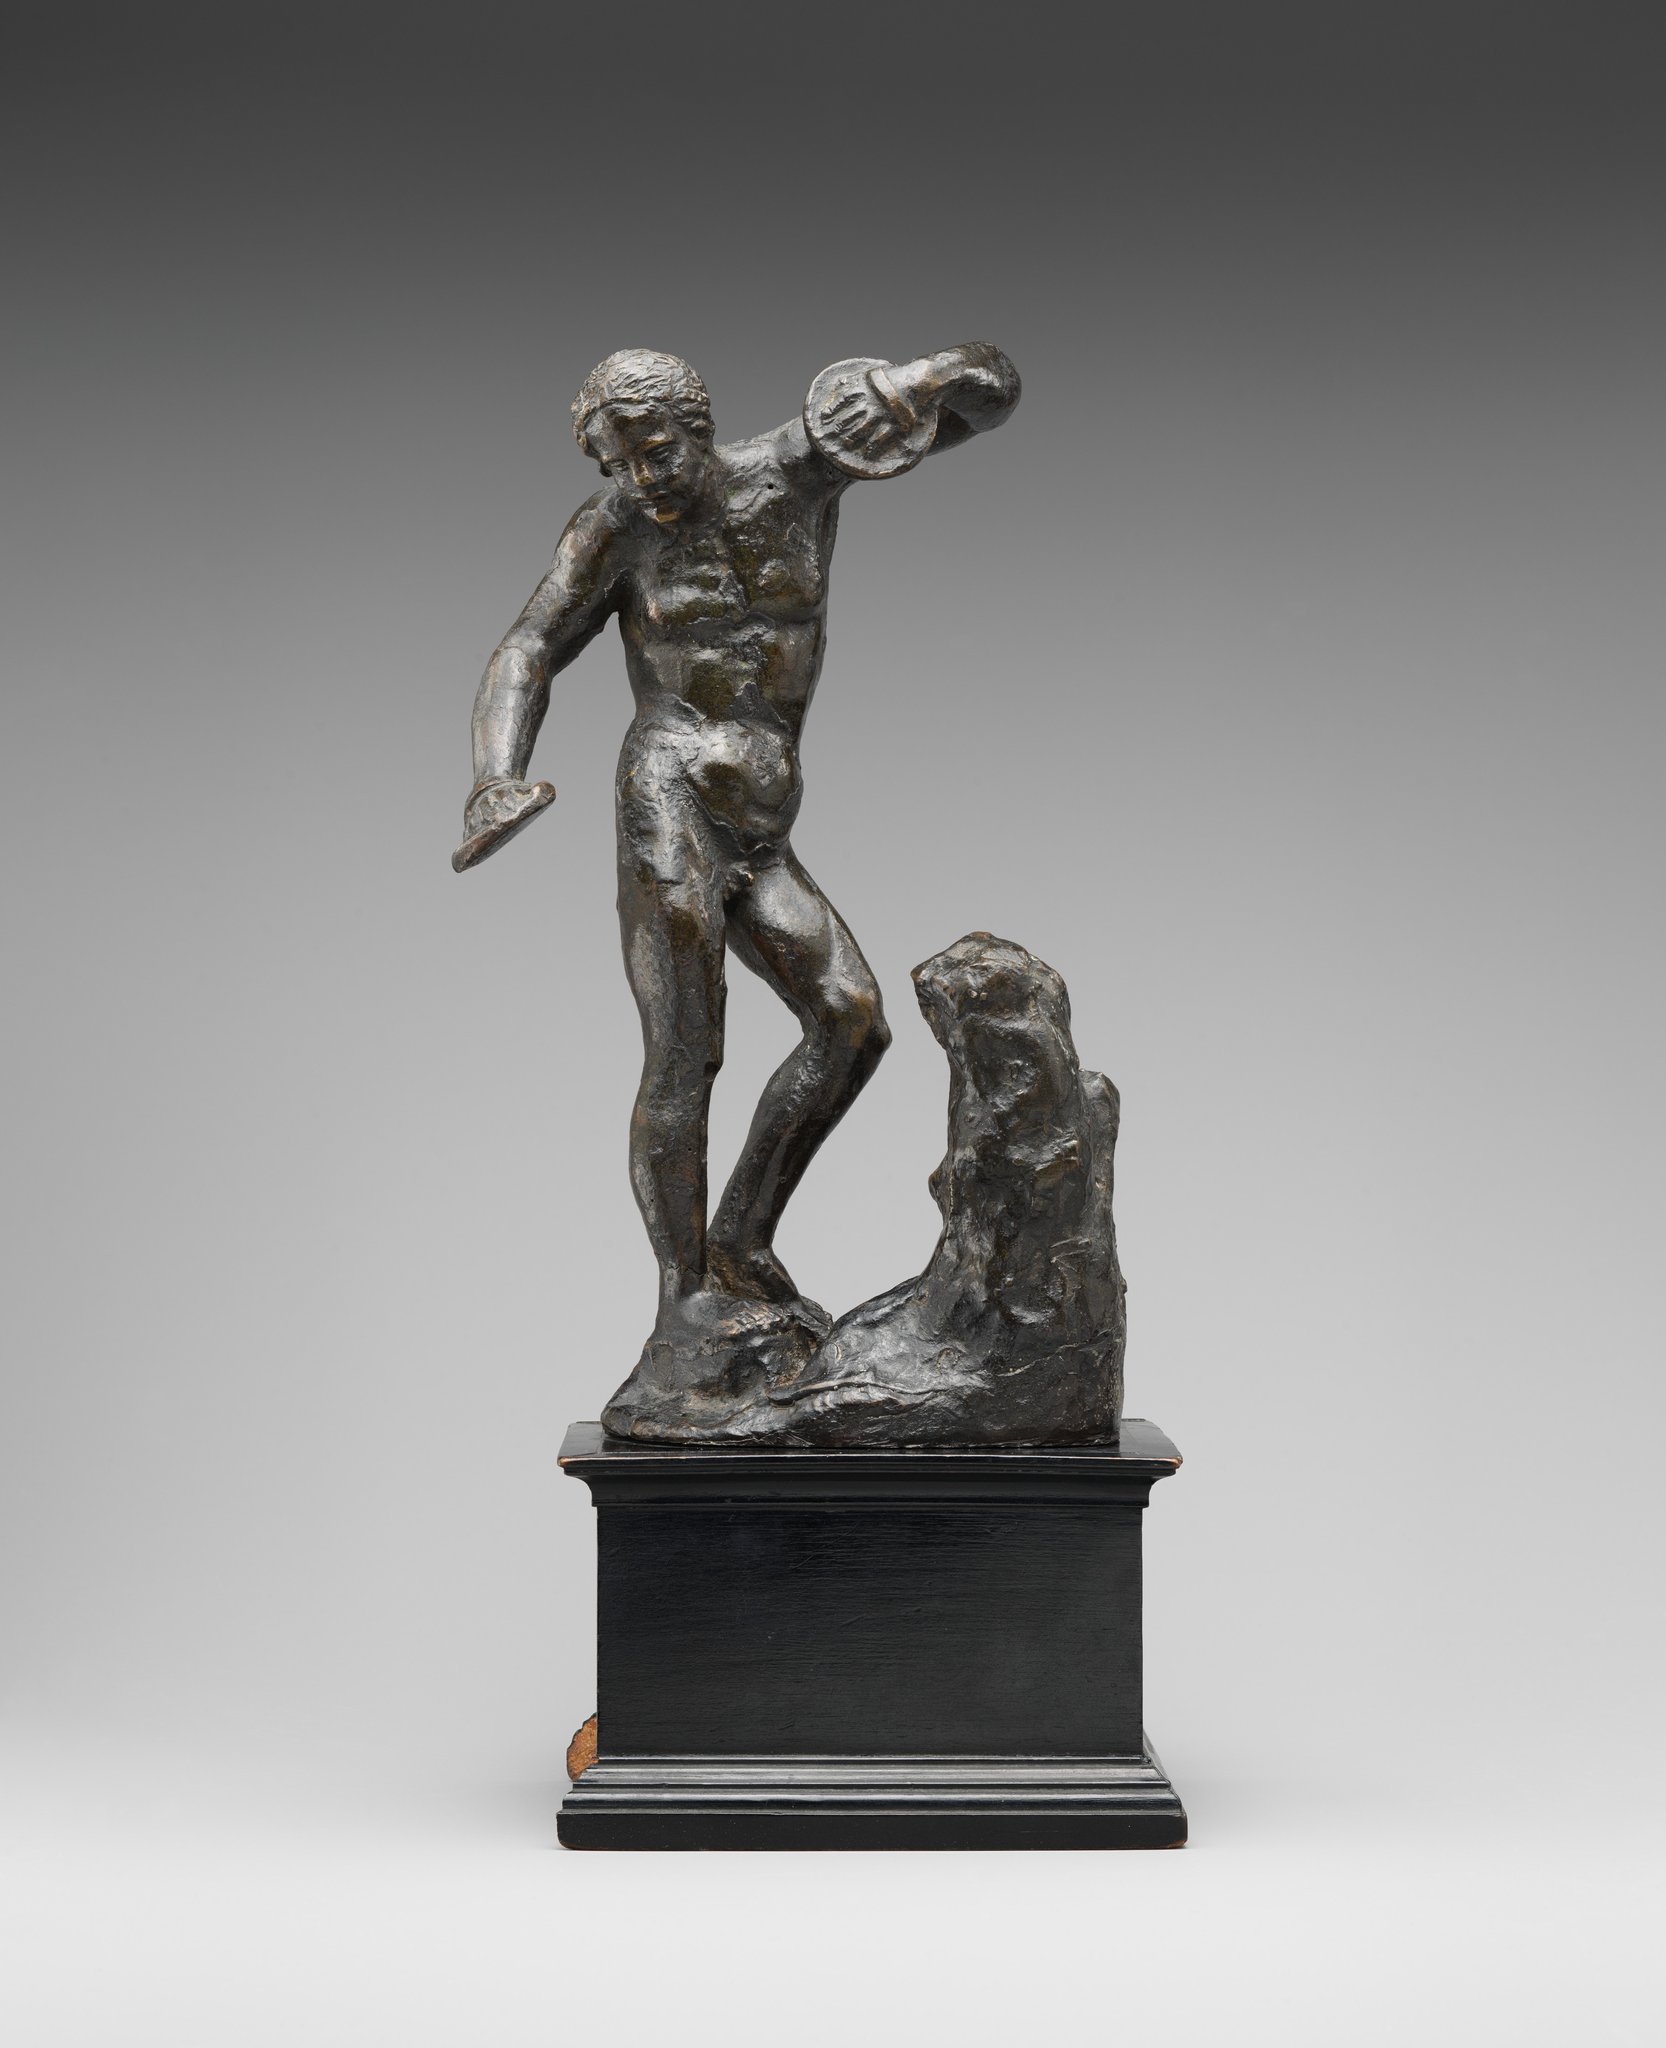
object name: statuette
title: Antique-style Statuette of Young Satyr with Cymbals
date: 1801-1900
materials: bronze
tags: musical instruments,satyrs